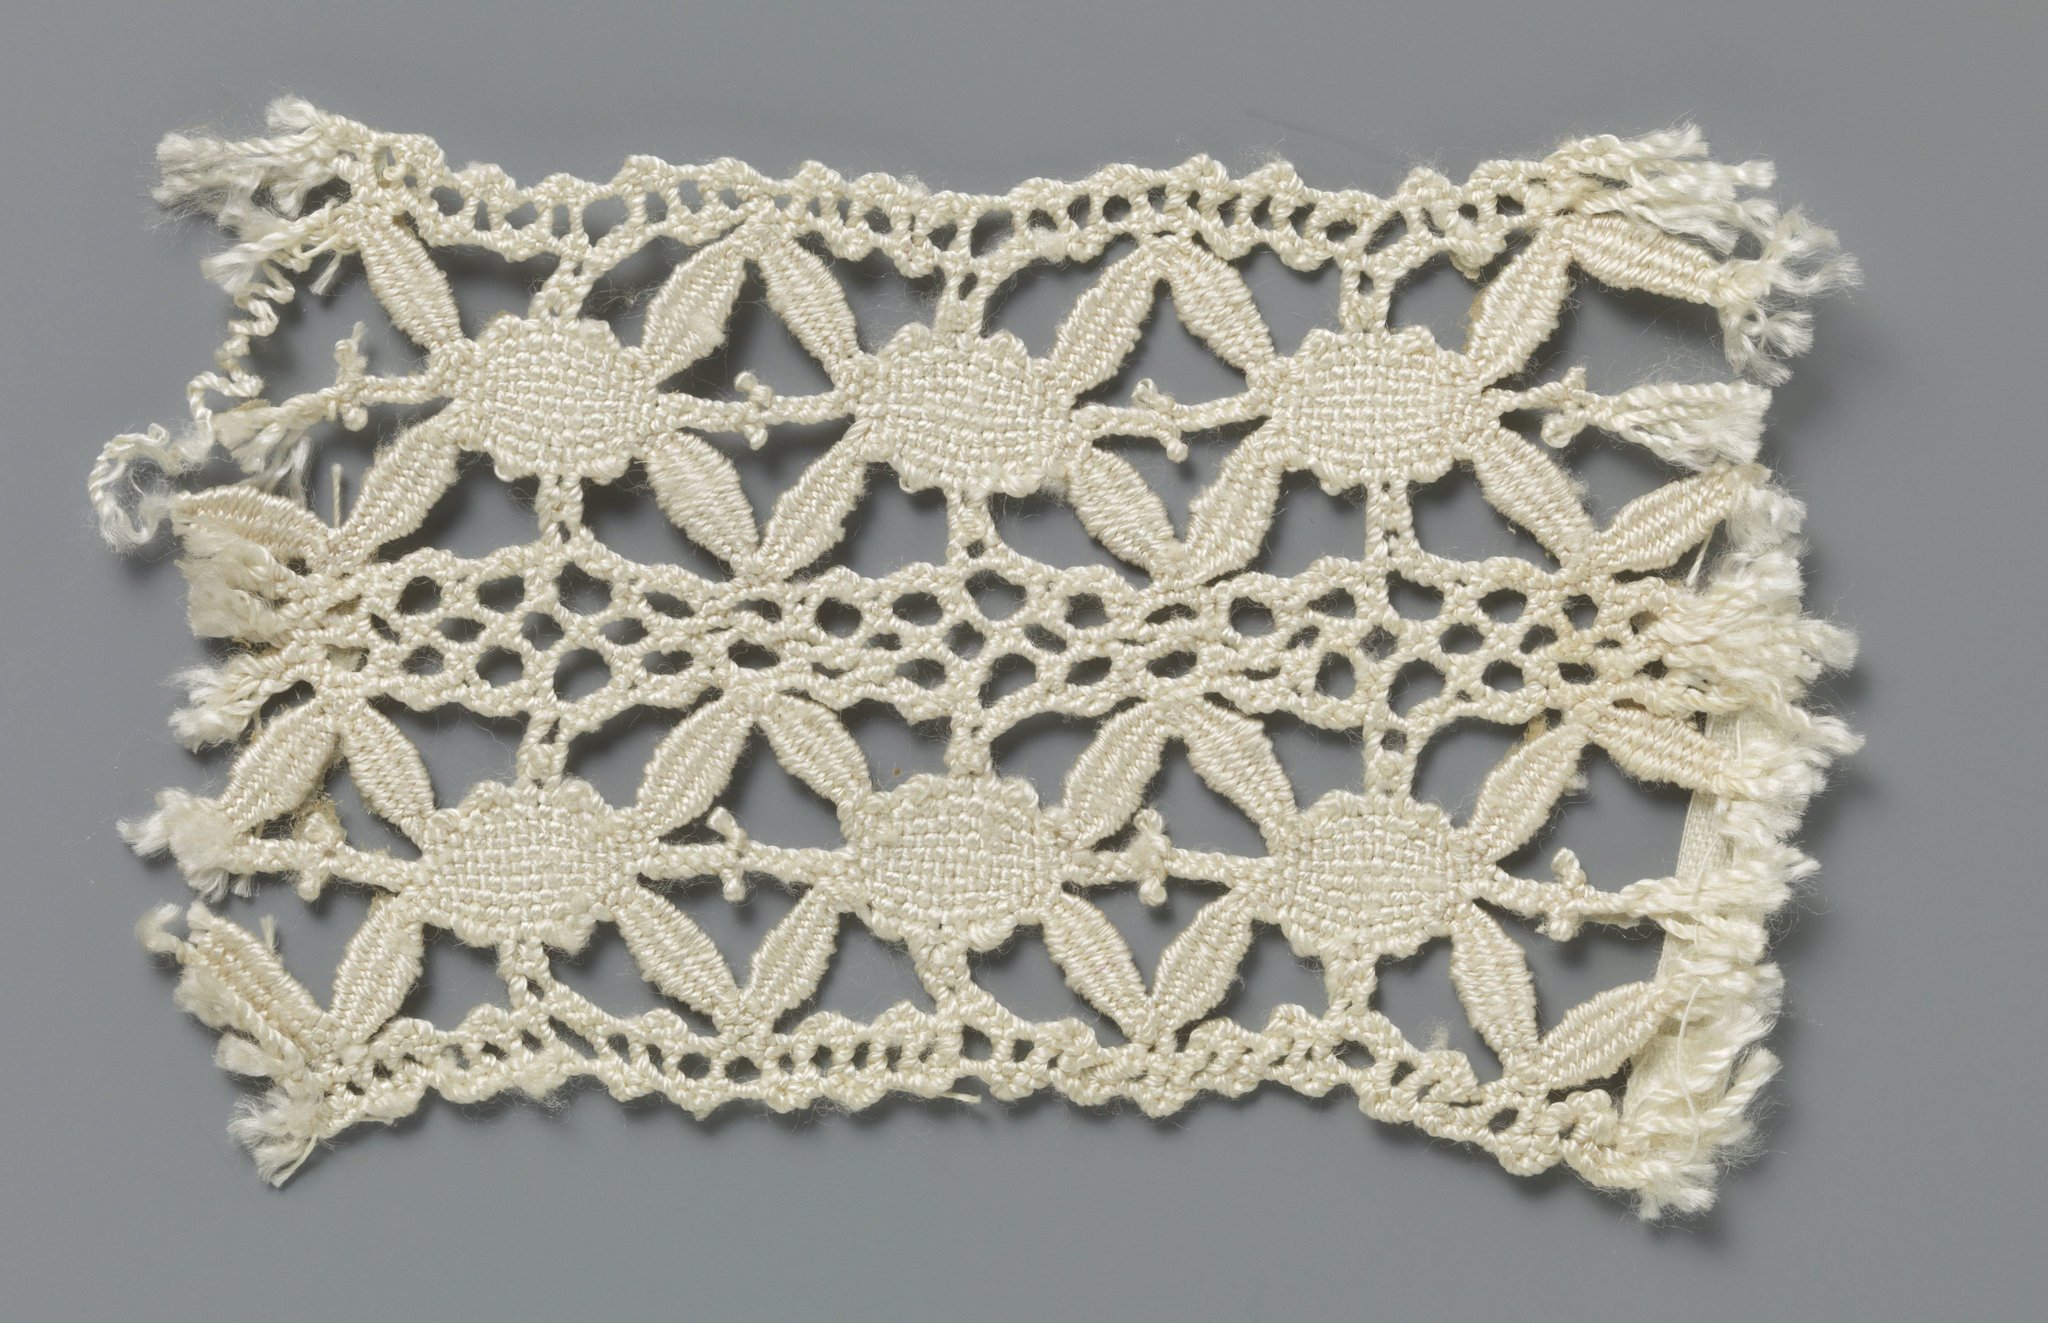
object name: strip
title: Strook kloskant met dubbele rij ovalen geflankeerd door vier blaadjes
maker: Anonymous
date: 1875-1899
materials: silk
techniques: lace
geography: russia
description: Strook naturelkleurige kloskant: Cluny-kant. Het zich herhalende en symmetrische patroon bestaat uit een dubbele rij ovalen. Elk ovaal is gemaakt in linnenslag en wordt geflankeerd door vier blaadjes gemaakt in vormslag. De ovalen zijn met elkaar verbonden door een vlecht met aan weerzijden een picot. En tussen de rijen ovalen loopt een band over het midden van de strook met een ovale traliegrond. Boven- en onderzijde van de strook zijn recht afgewerkt met vergelijkbare maar smallere banden met een enkele rij ovale mazen.